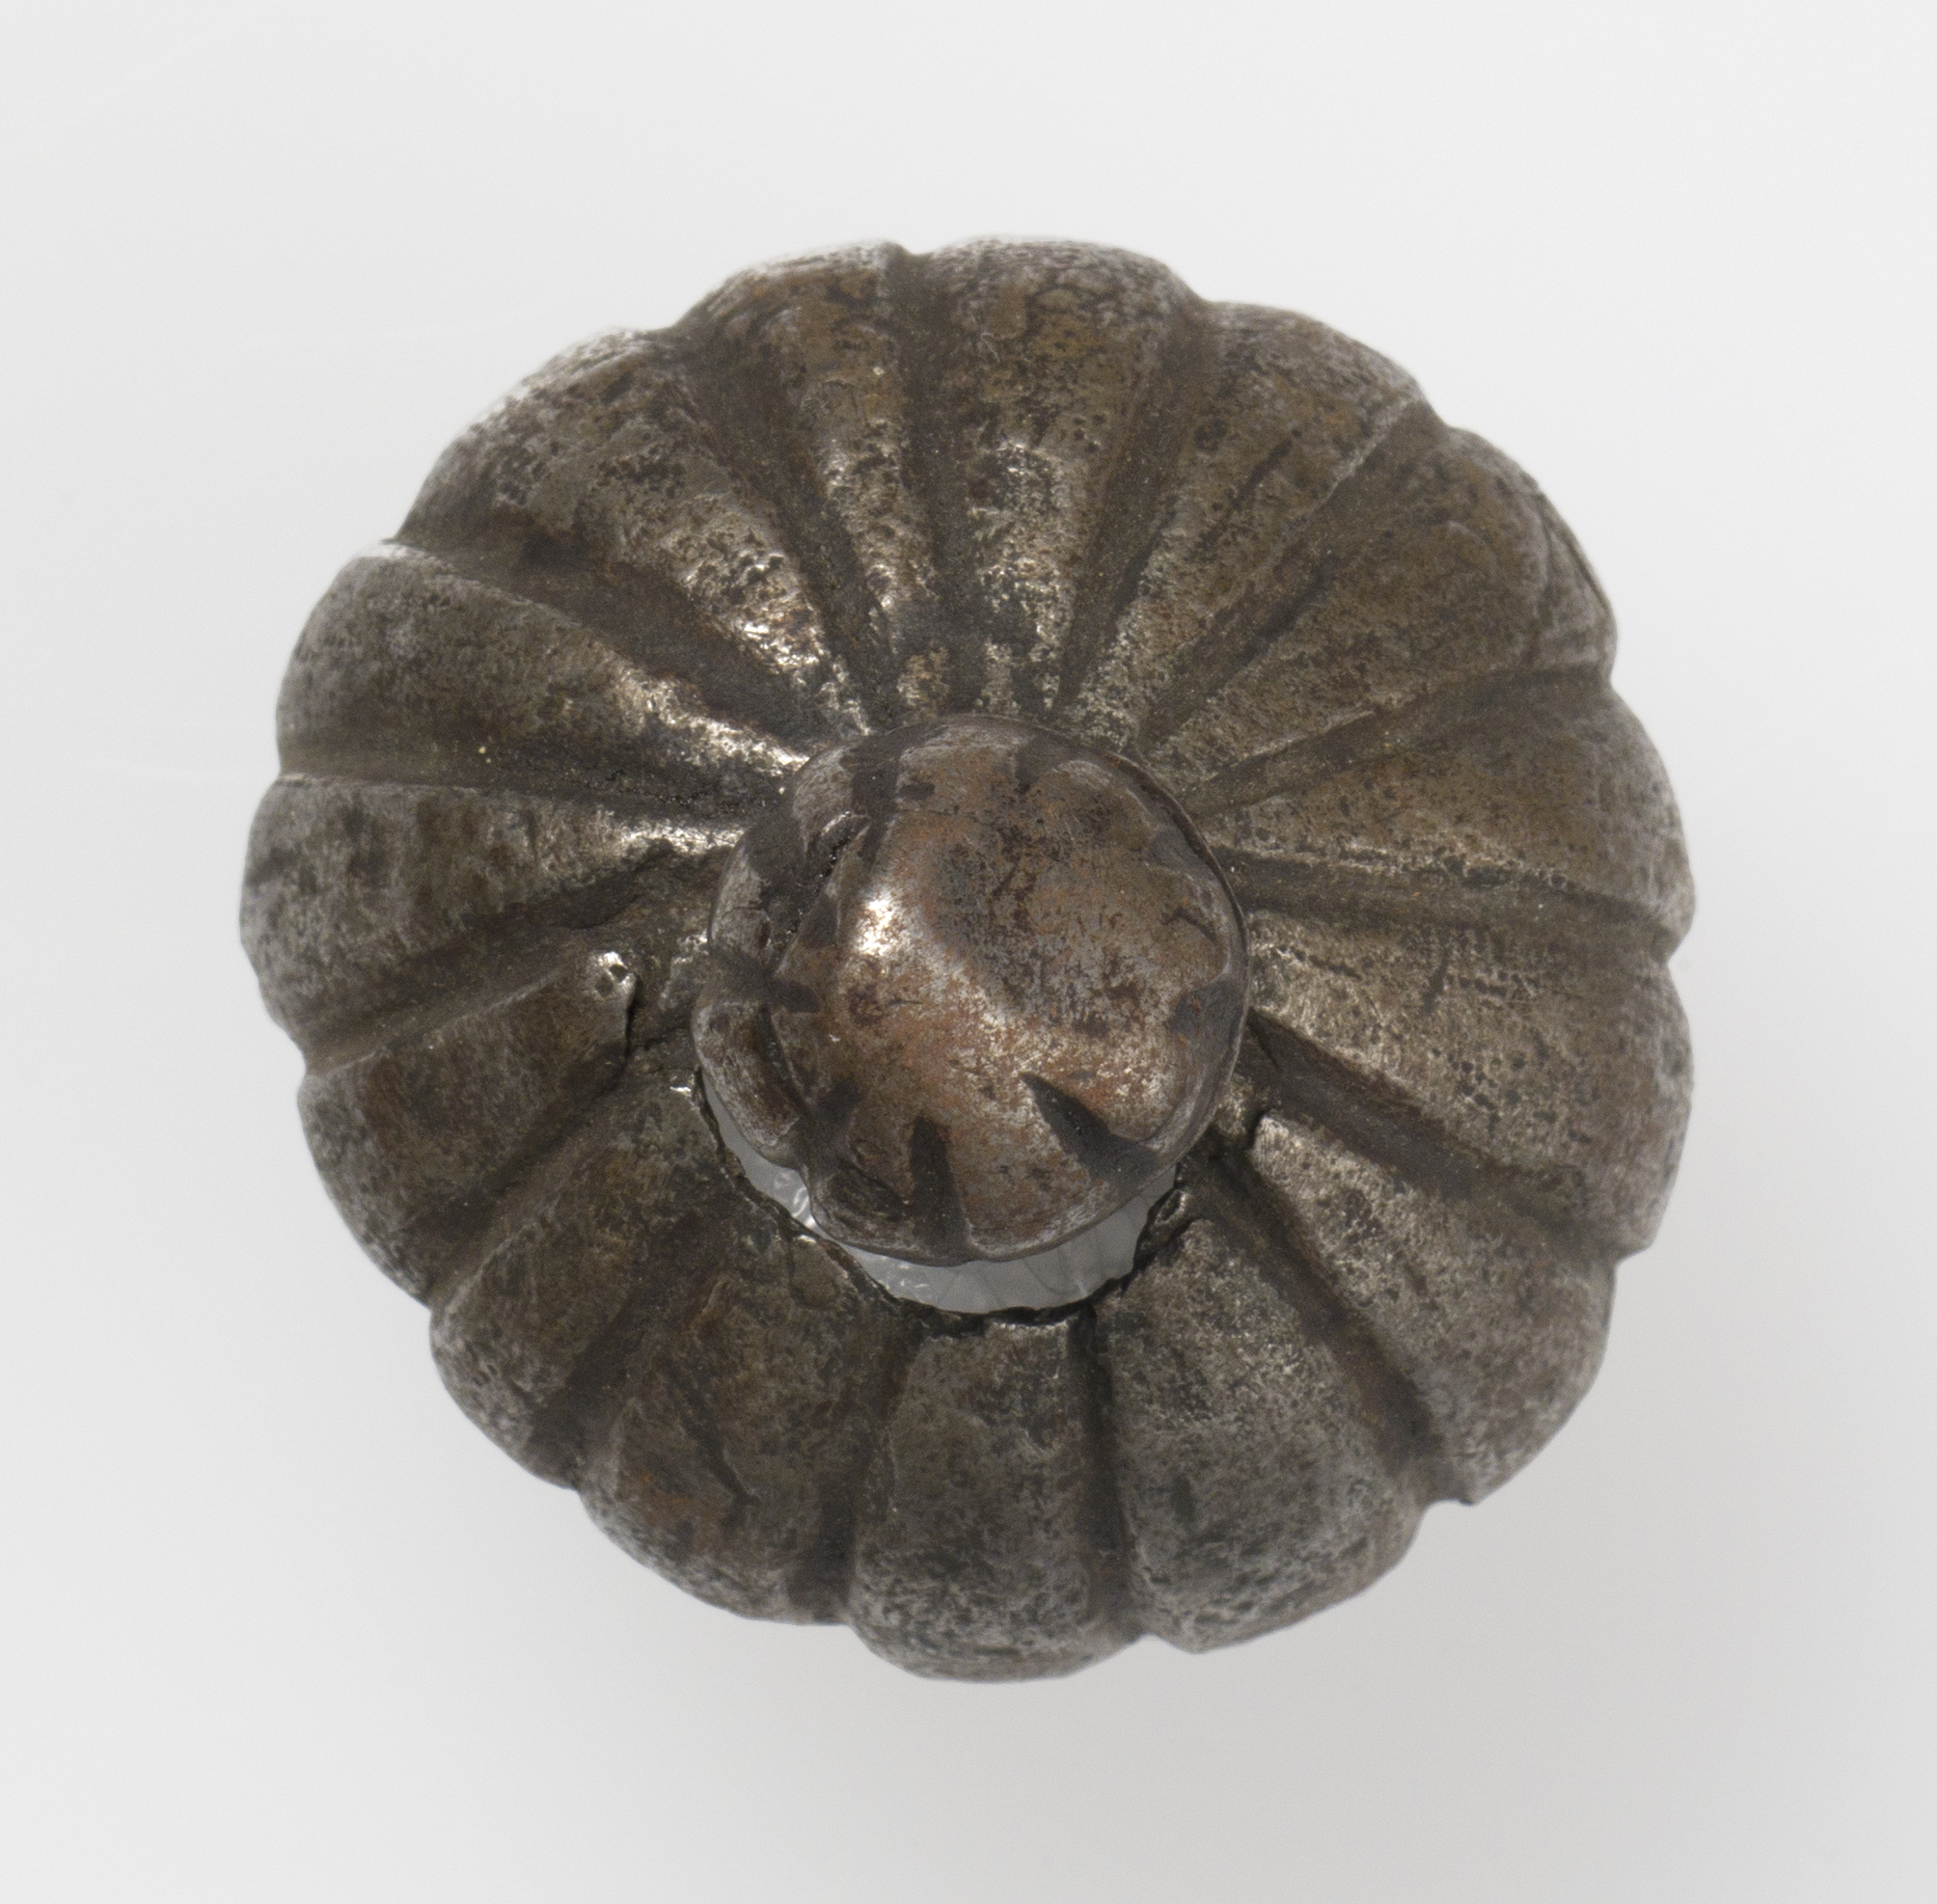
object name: bos and nail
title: Boss and Nail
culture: european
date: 1401-1600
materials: iron